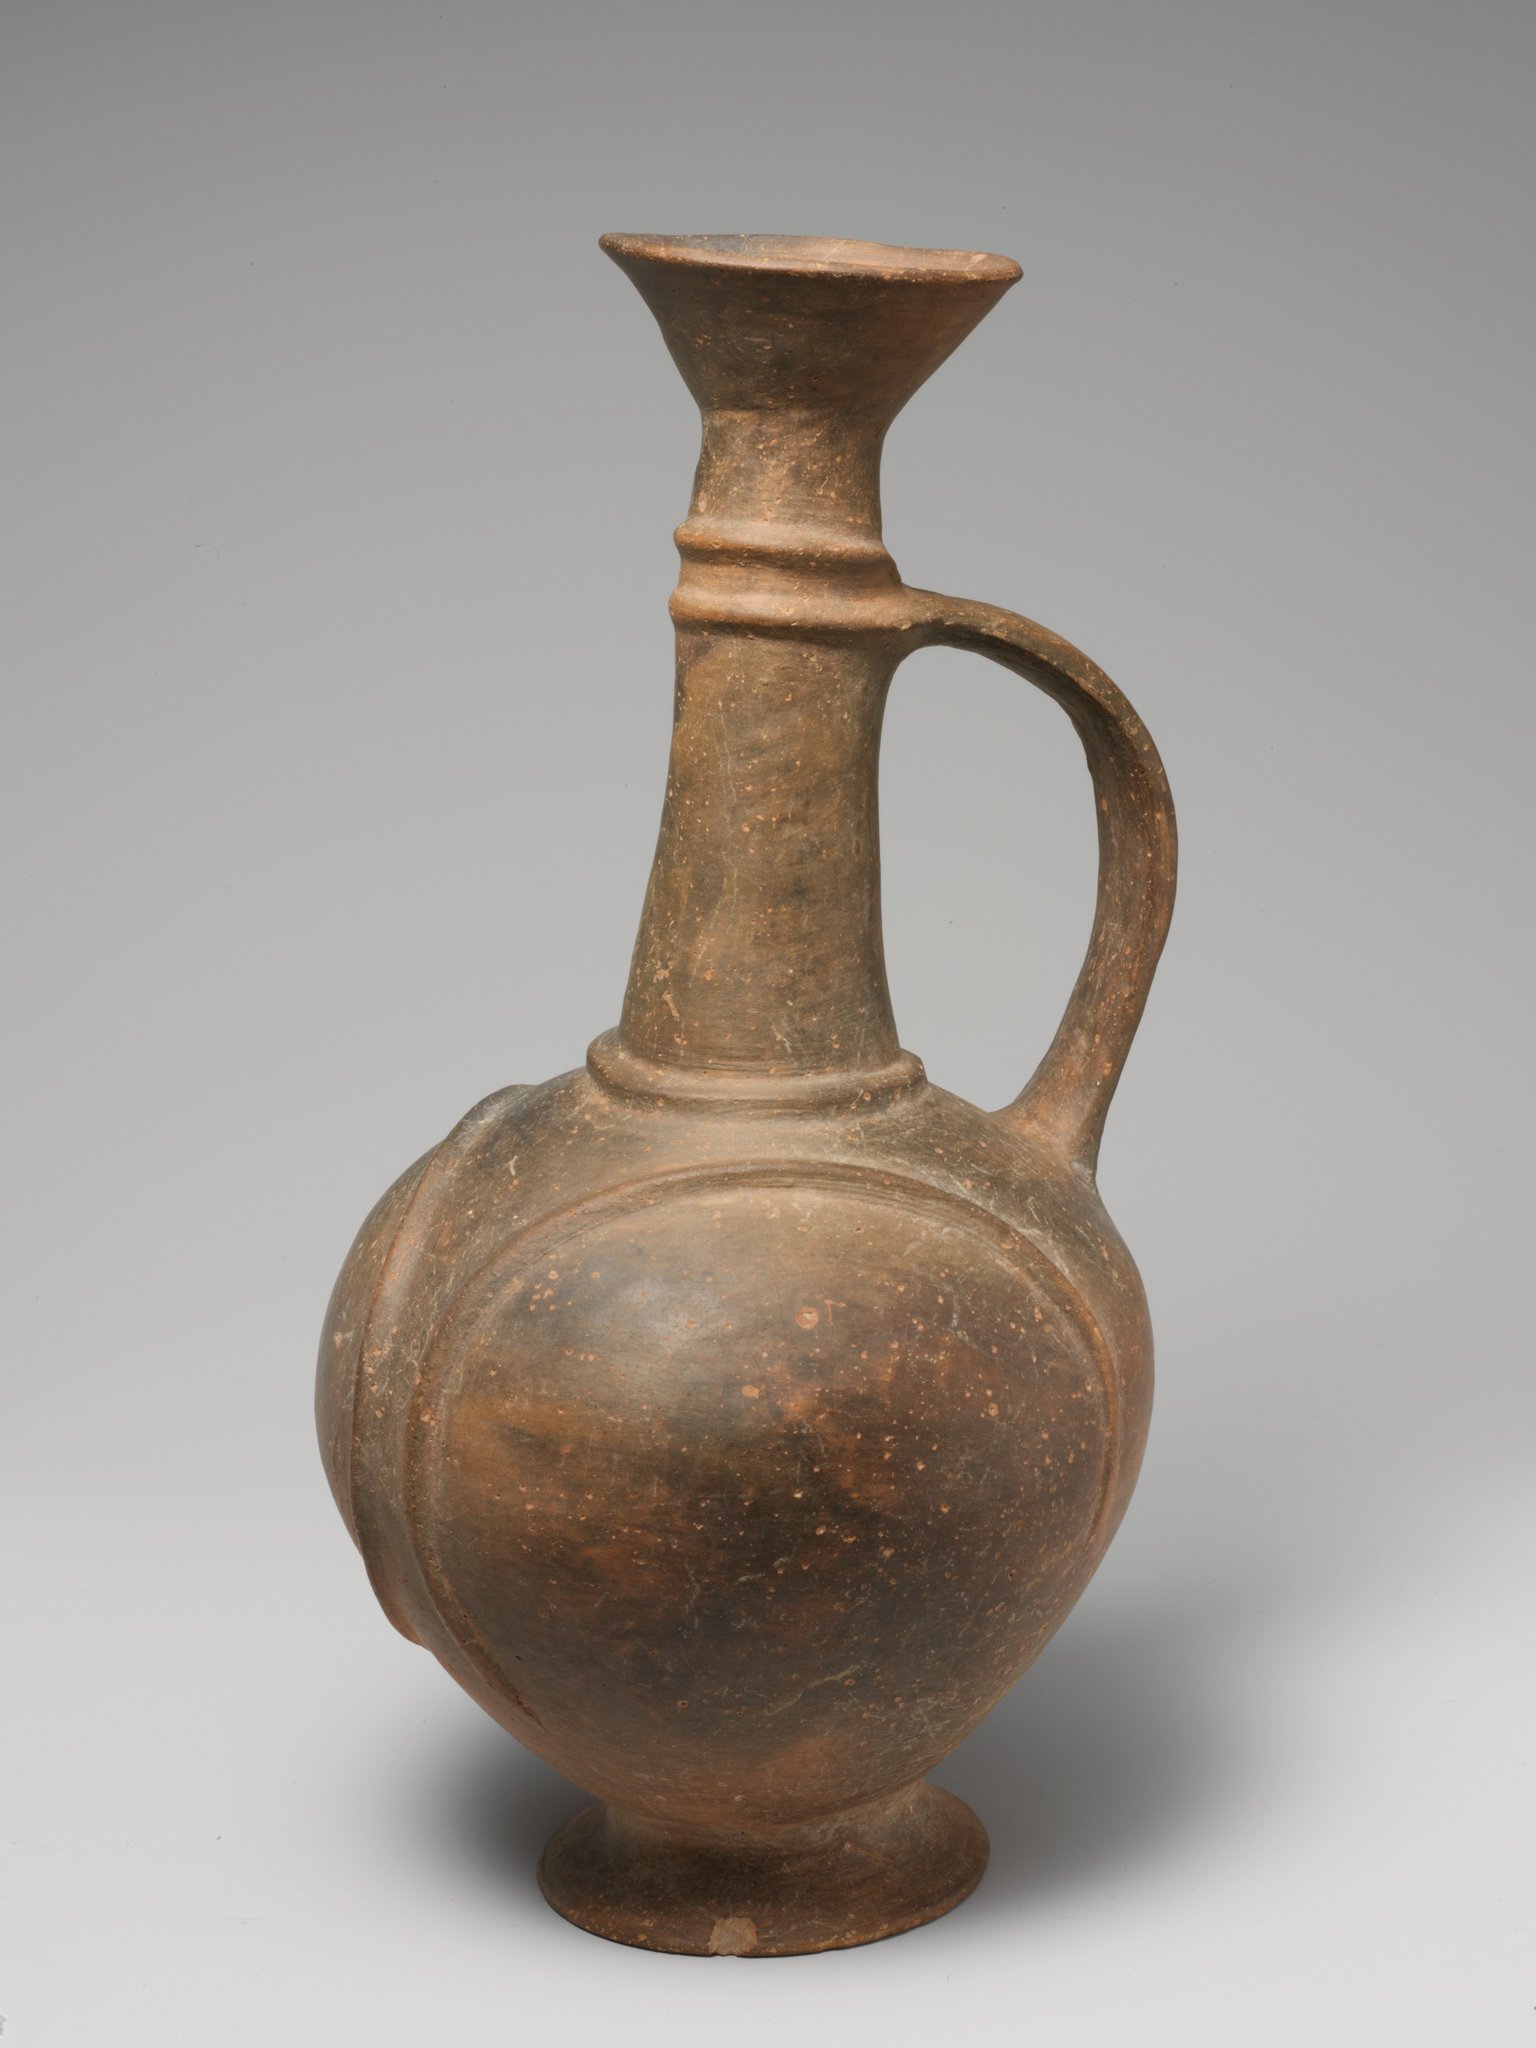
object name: jug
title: Terracotta jug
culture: cypriot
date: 1600-1450 BCE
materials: terracotta